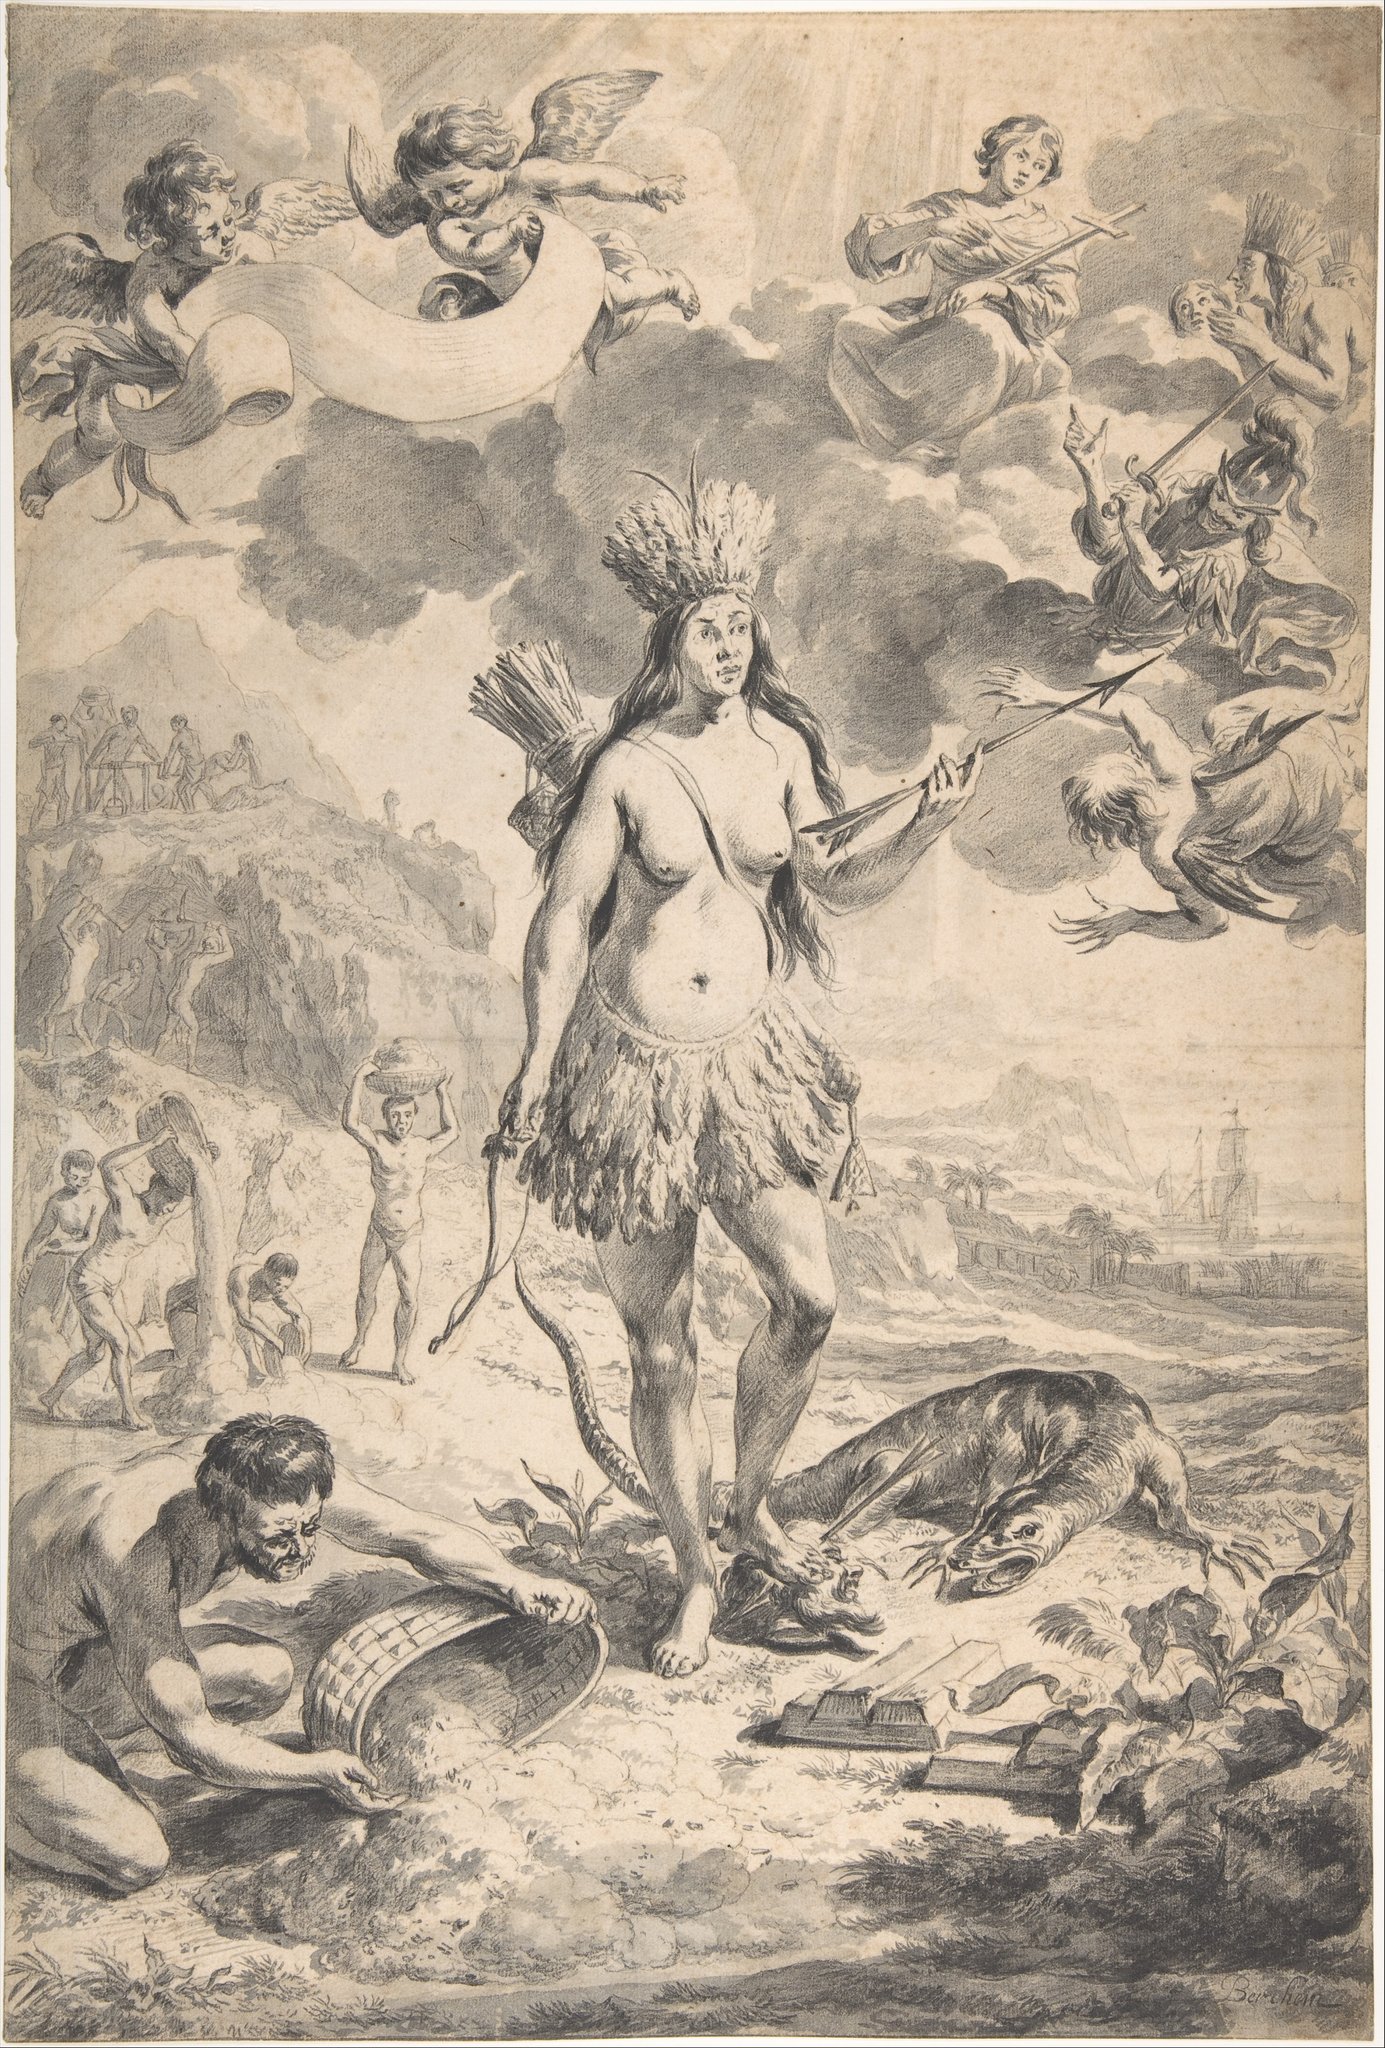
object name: drawing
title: Allegory of America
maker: nicolaes pietersz berchem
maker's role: artist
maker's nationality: dutch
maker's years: 1620-1683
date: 1634-1700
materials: chalk, ink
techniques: brush, incising, transfer, wash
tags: bow and arrow,men,women,working